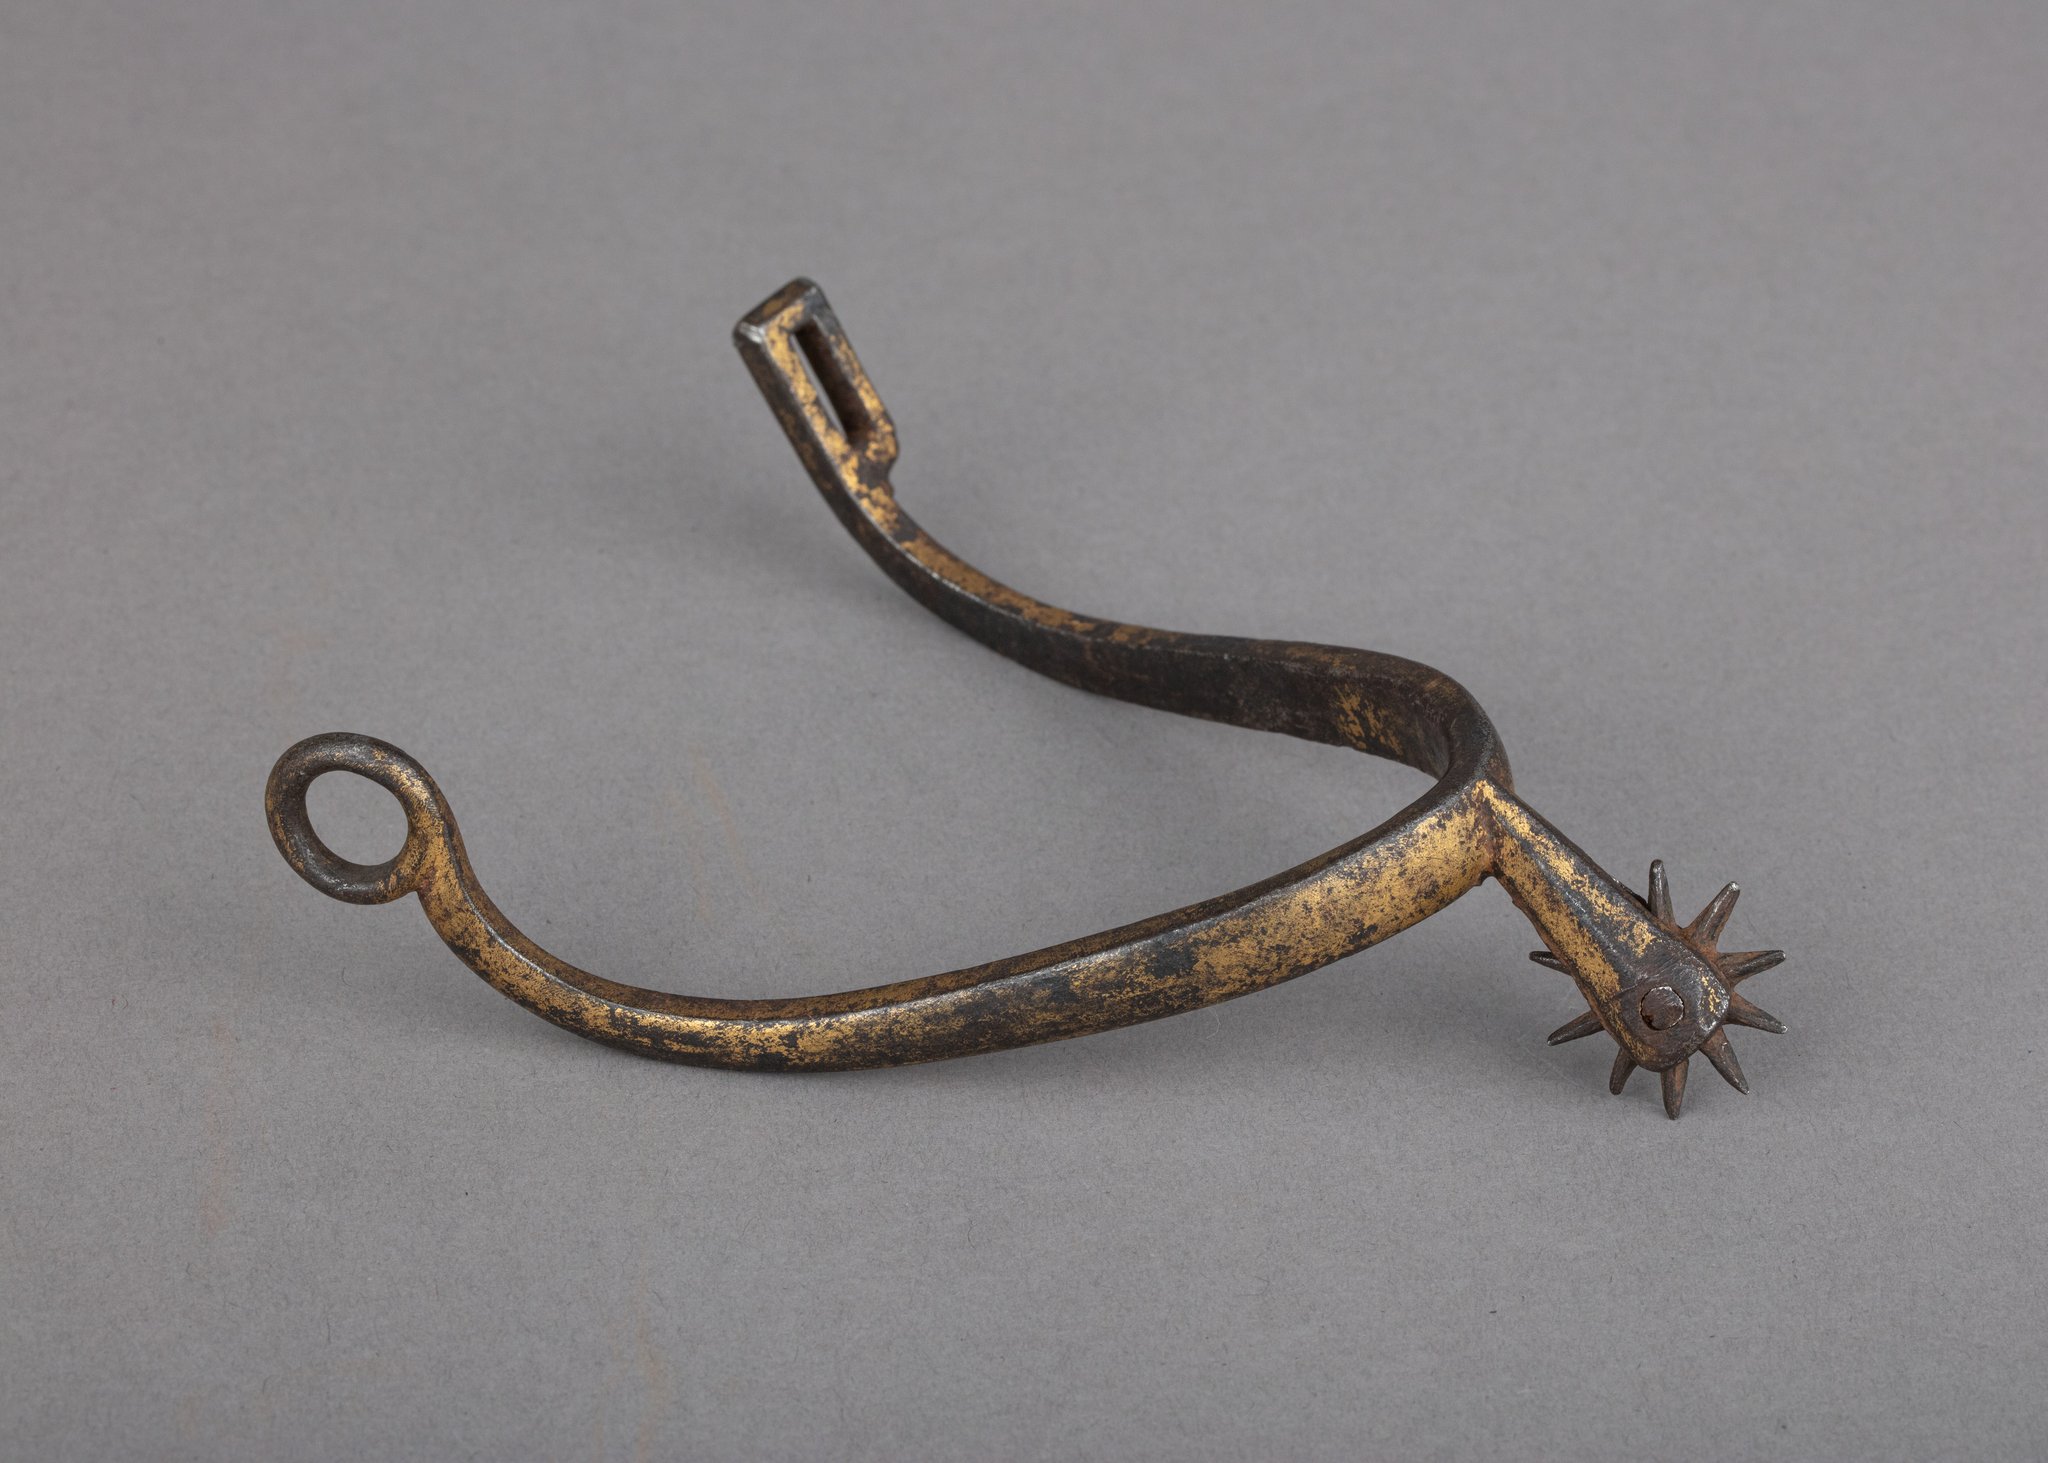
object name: spur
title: Rowel Spur (Left) in 13th-century Style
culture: european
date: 1801-1900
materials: gold, metal alloy